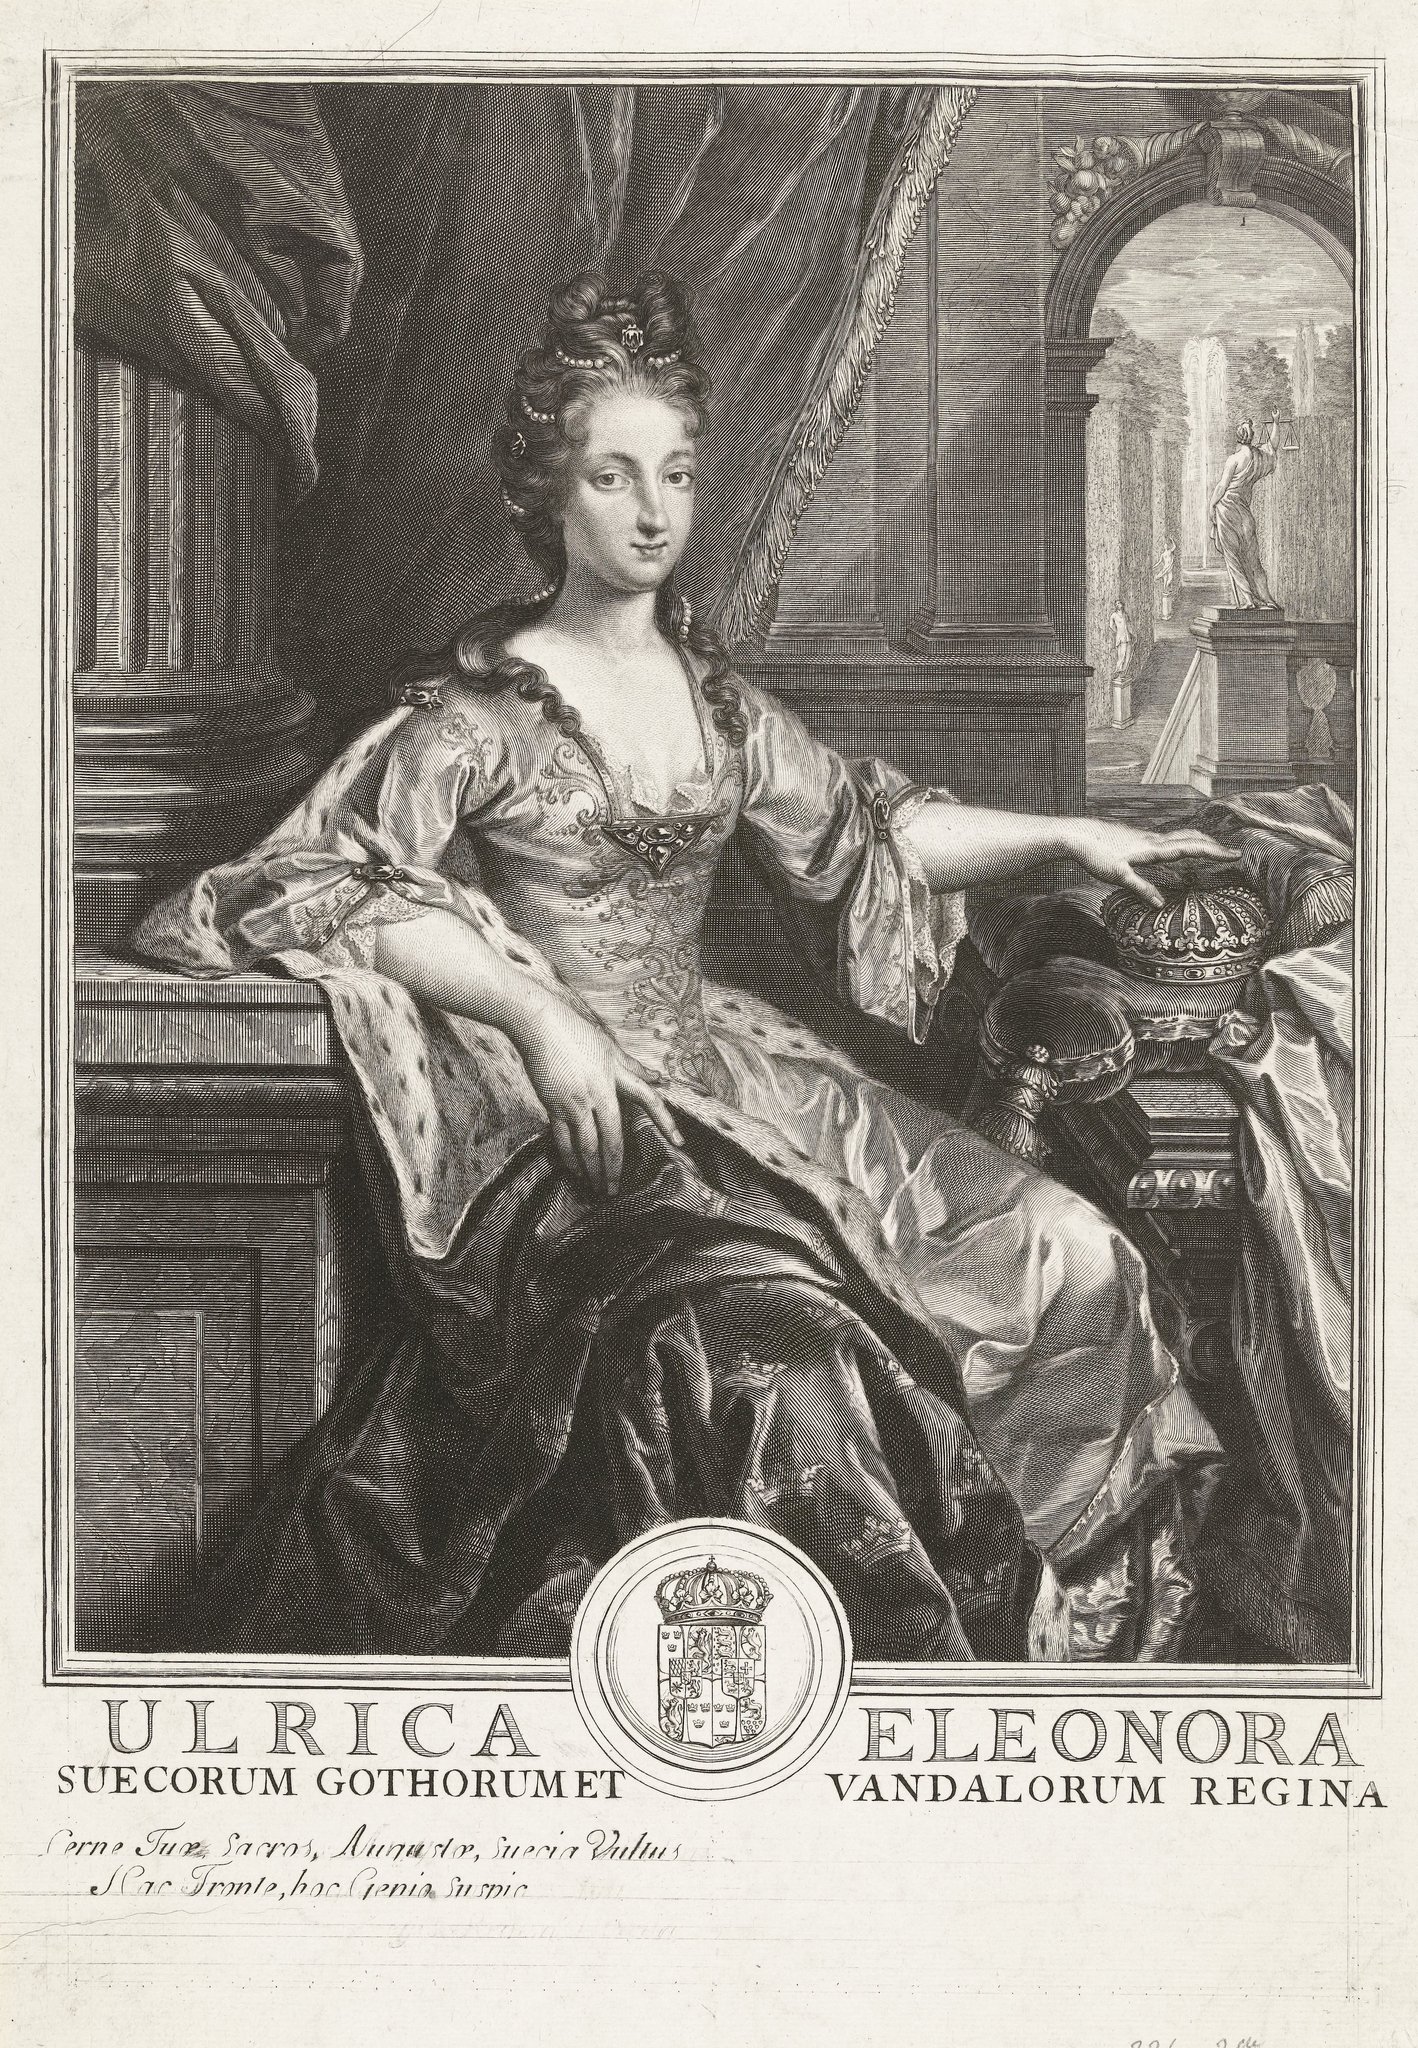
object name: print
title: Portret van Ulrika Eleonora van Denemarken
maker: gerard edelinck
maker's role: print maker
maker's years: 1640-1707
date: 1652-1707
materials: paper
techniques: engraving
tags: koningin, ulrika eleonora van denemarken (koningin van zweden)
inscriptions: collector's mark: Lugt 240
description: Ulrika Eleonora van Denemarken (1656-1693), koningin van Zweden, zittend afgebeeld met haar hand boven een op een kussen gelegen kroon. Onderaan de voorstelling een cirkelvormig cartouche met een wapen.